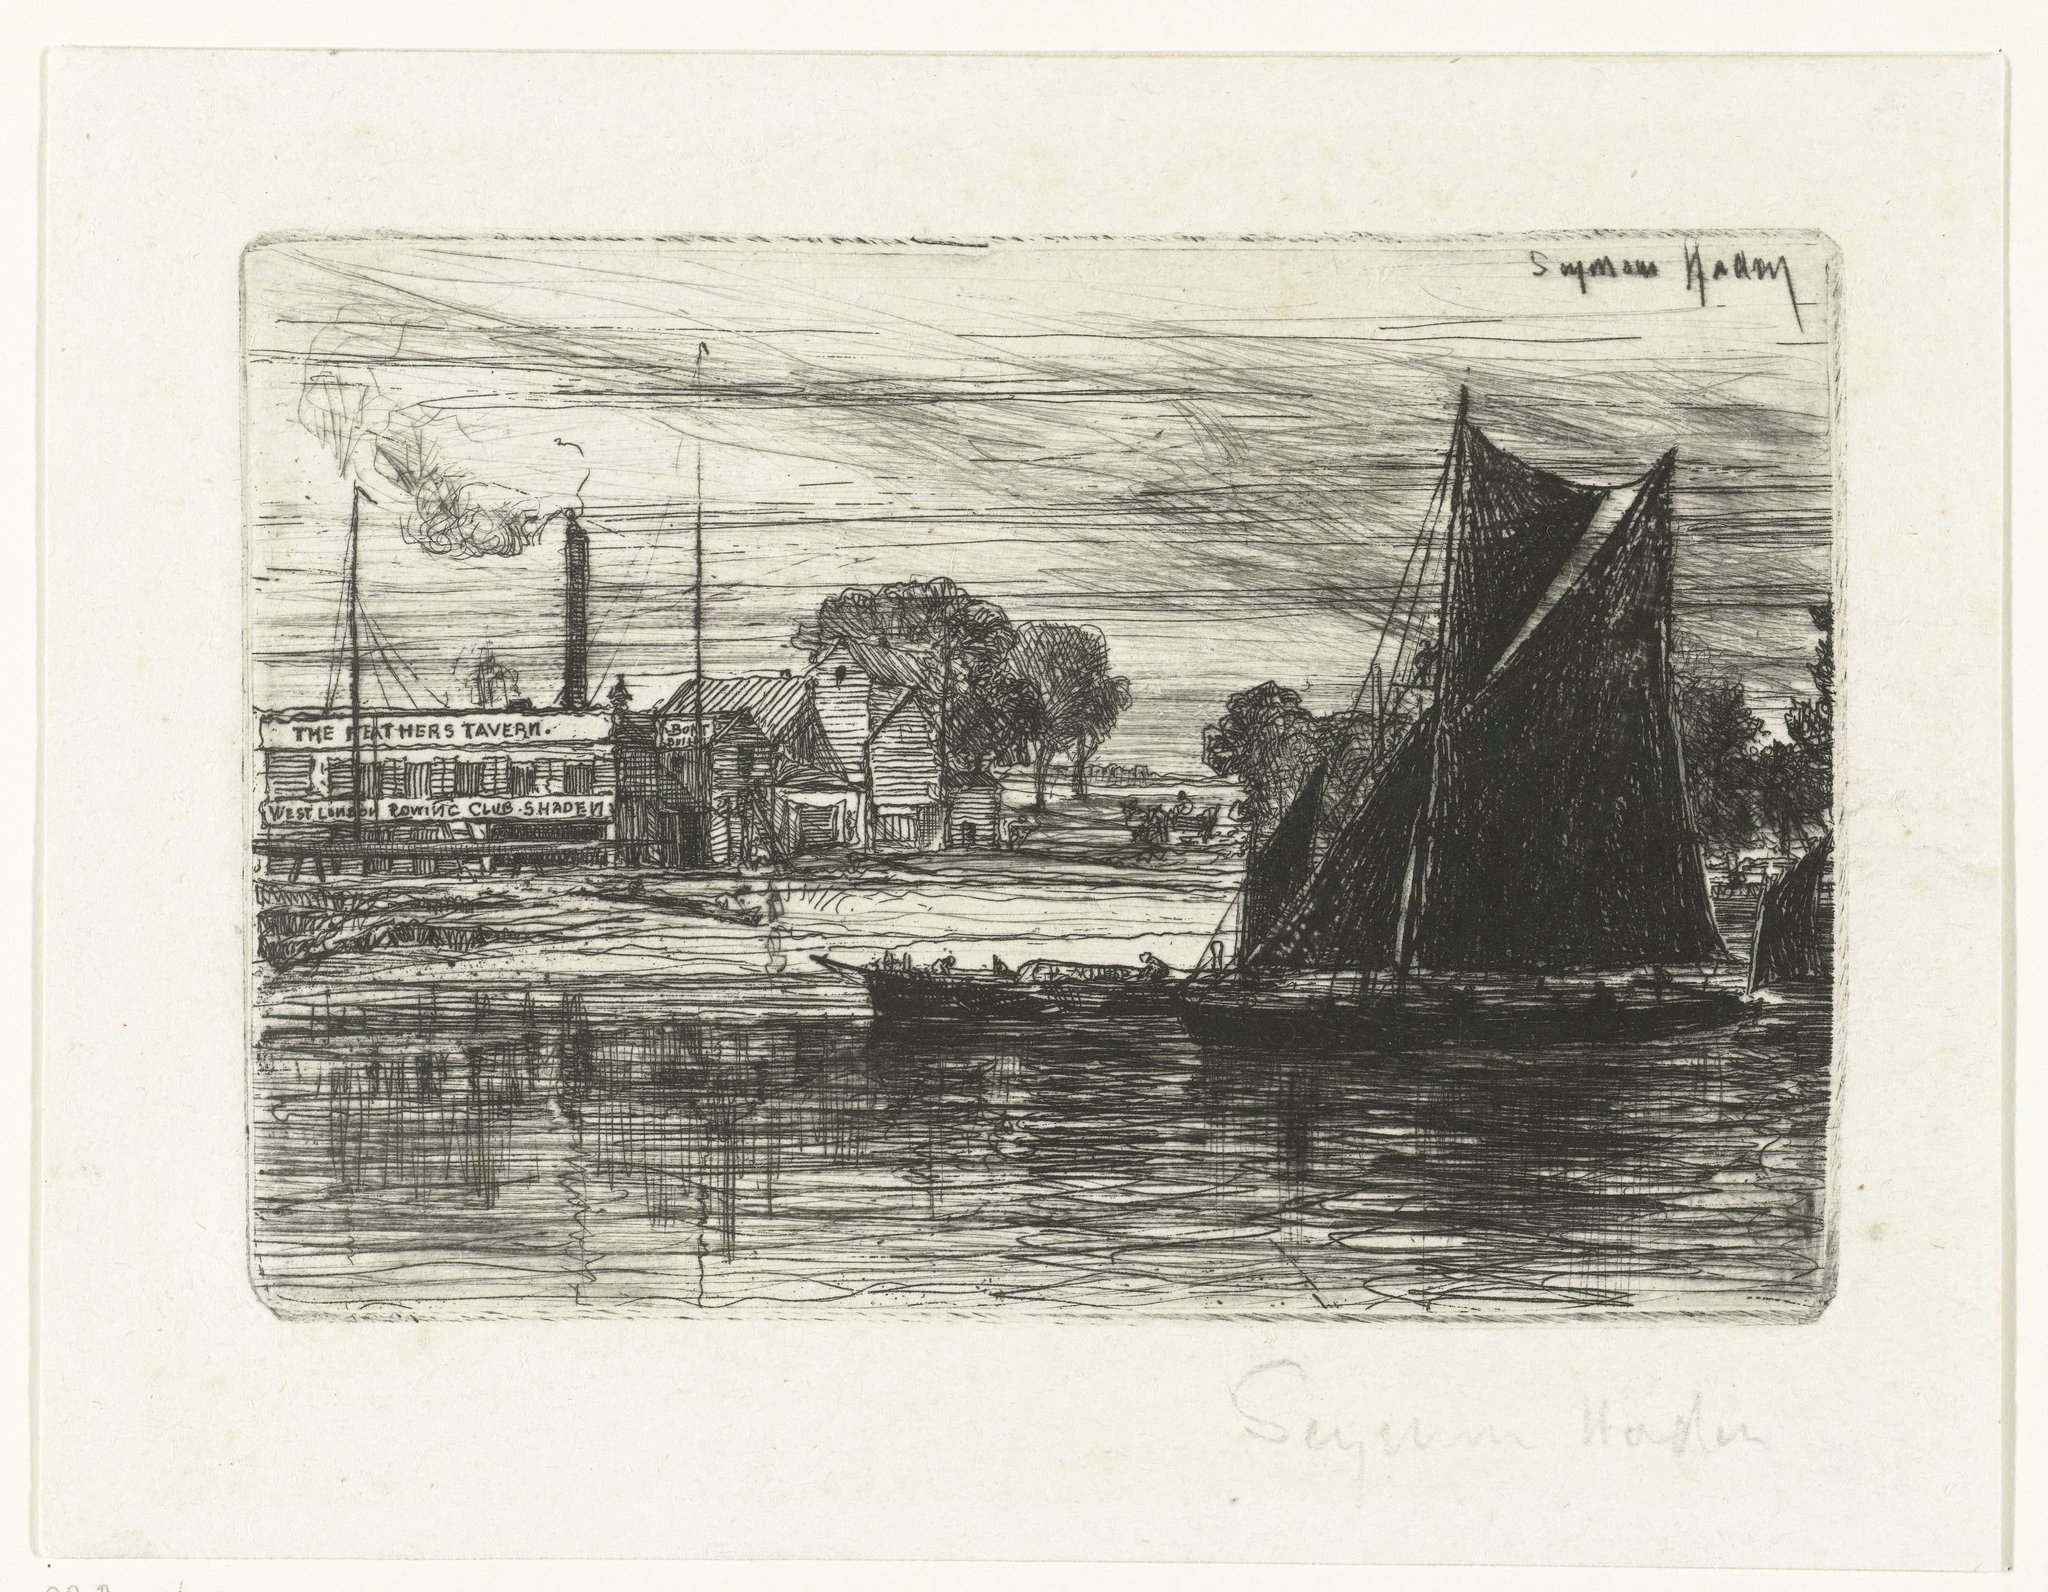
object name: print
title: West London Rowing Club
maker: francis seymour-haden (sir)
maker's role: print maker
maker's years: 1818-1910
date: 1865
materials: paper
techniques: drypoint, etching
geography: england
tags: sailing-ship, sailing-boat, river, thames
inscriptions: collector's mark: ‘d’, collector's mark: Lugt 2228, collector's mark, signature: ‘Seymour Haden’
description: De rivier de Theems bij Mortlake, met rechts een zeilschip. Links op de oever het clubgebouw van de West Londen Rowing Club, The Feathers Tavern.